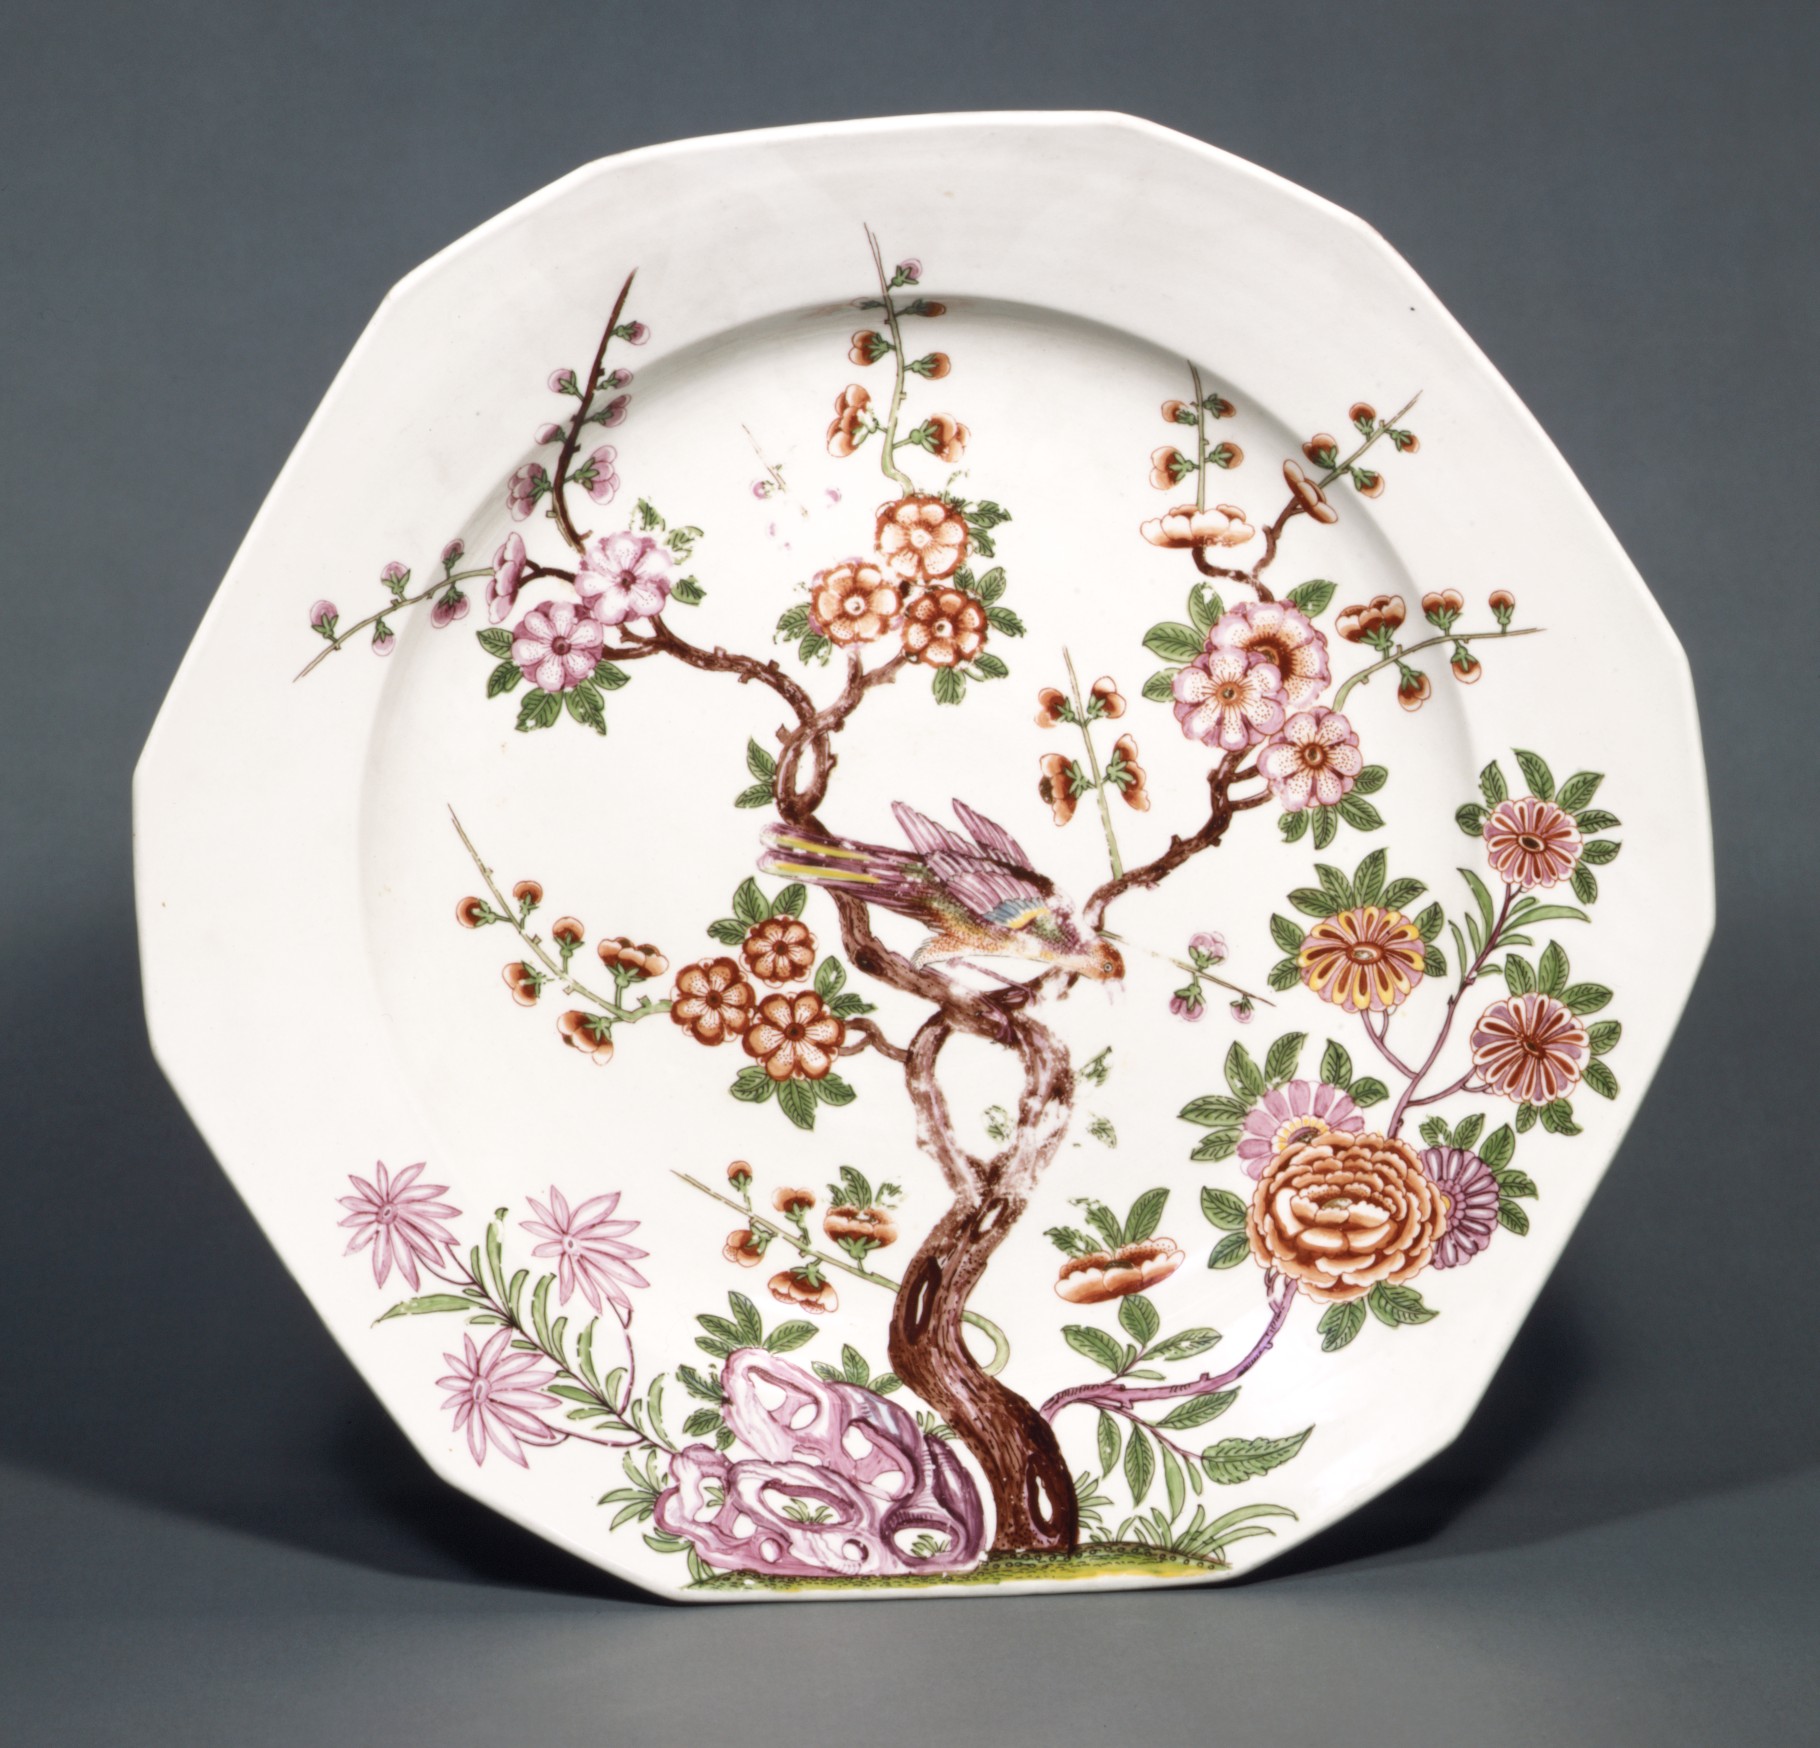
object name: dish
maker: vienna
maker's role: manufactory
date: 1722-1723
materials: hard paste porcelain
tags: birds,flowers